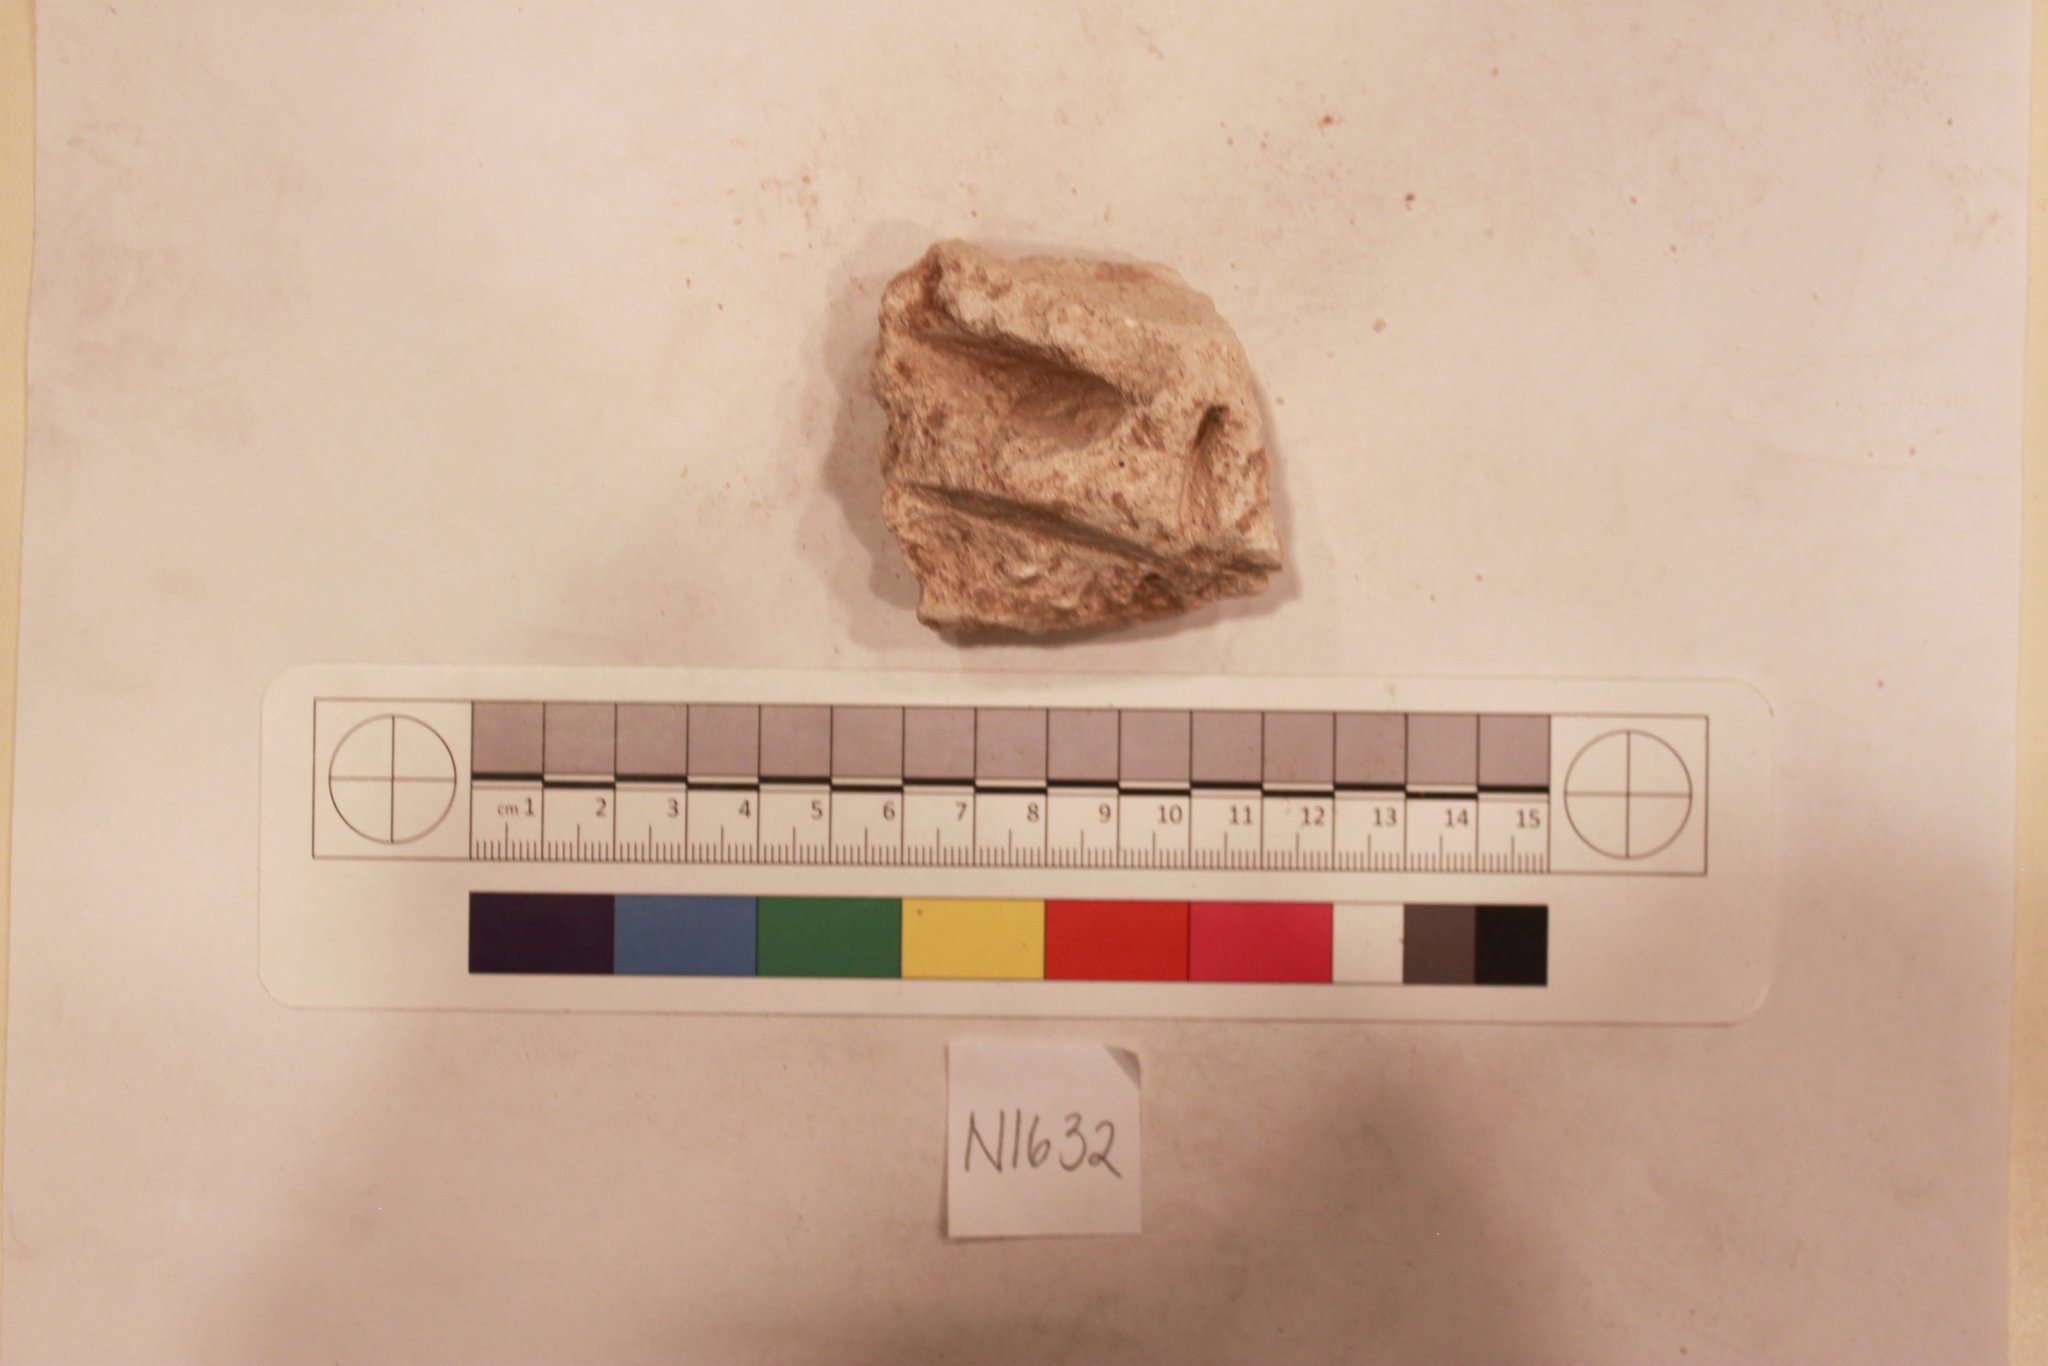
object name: fragment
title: Stucco Fragment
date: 701-1200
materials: plaster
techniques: carving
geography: iran